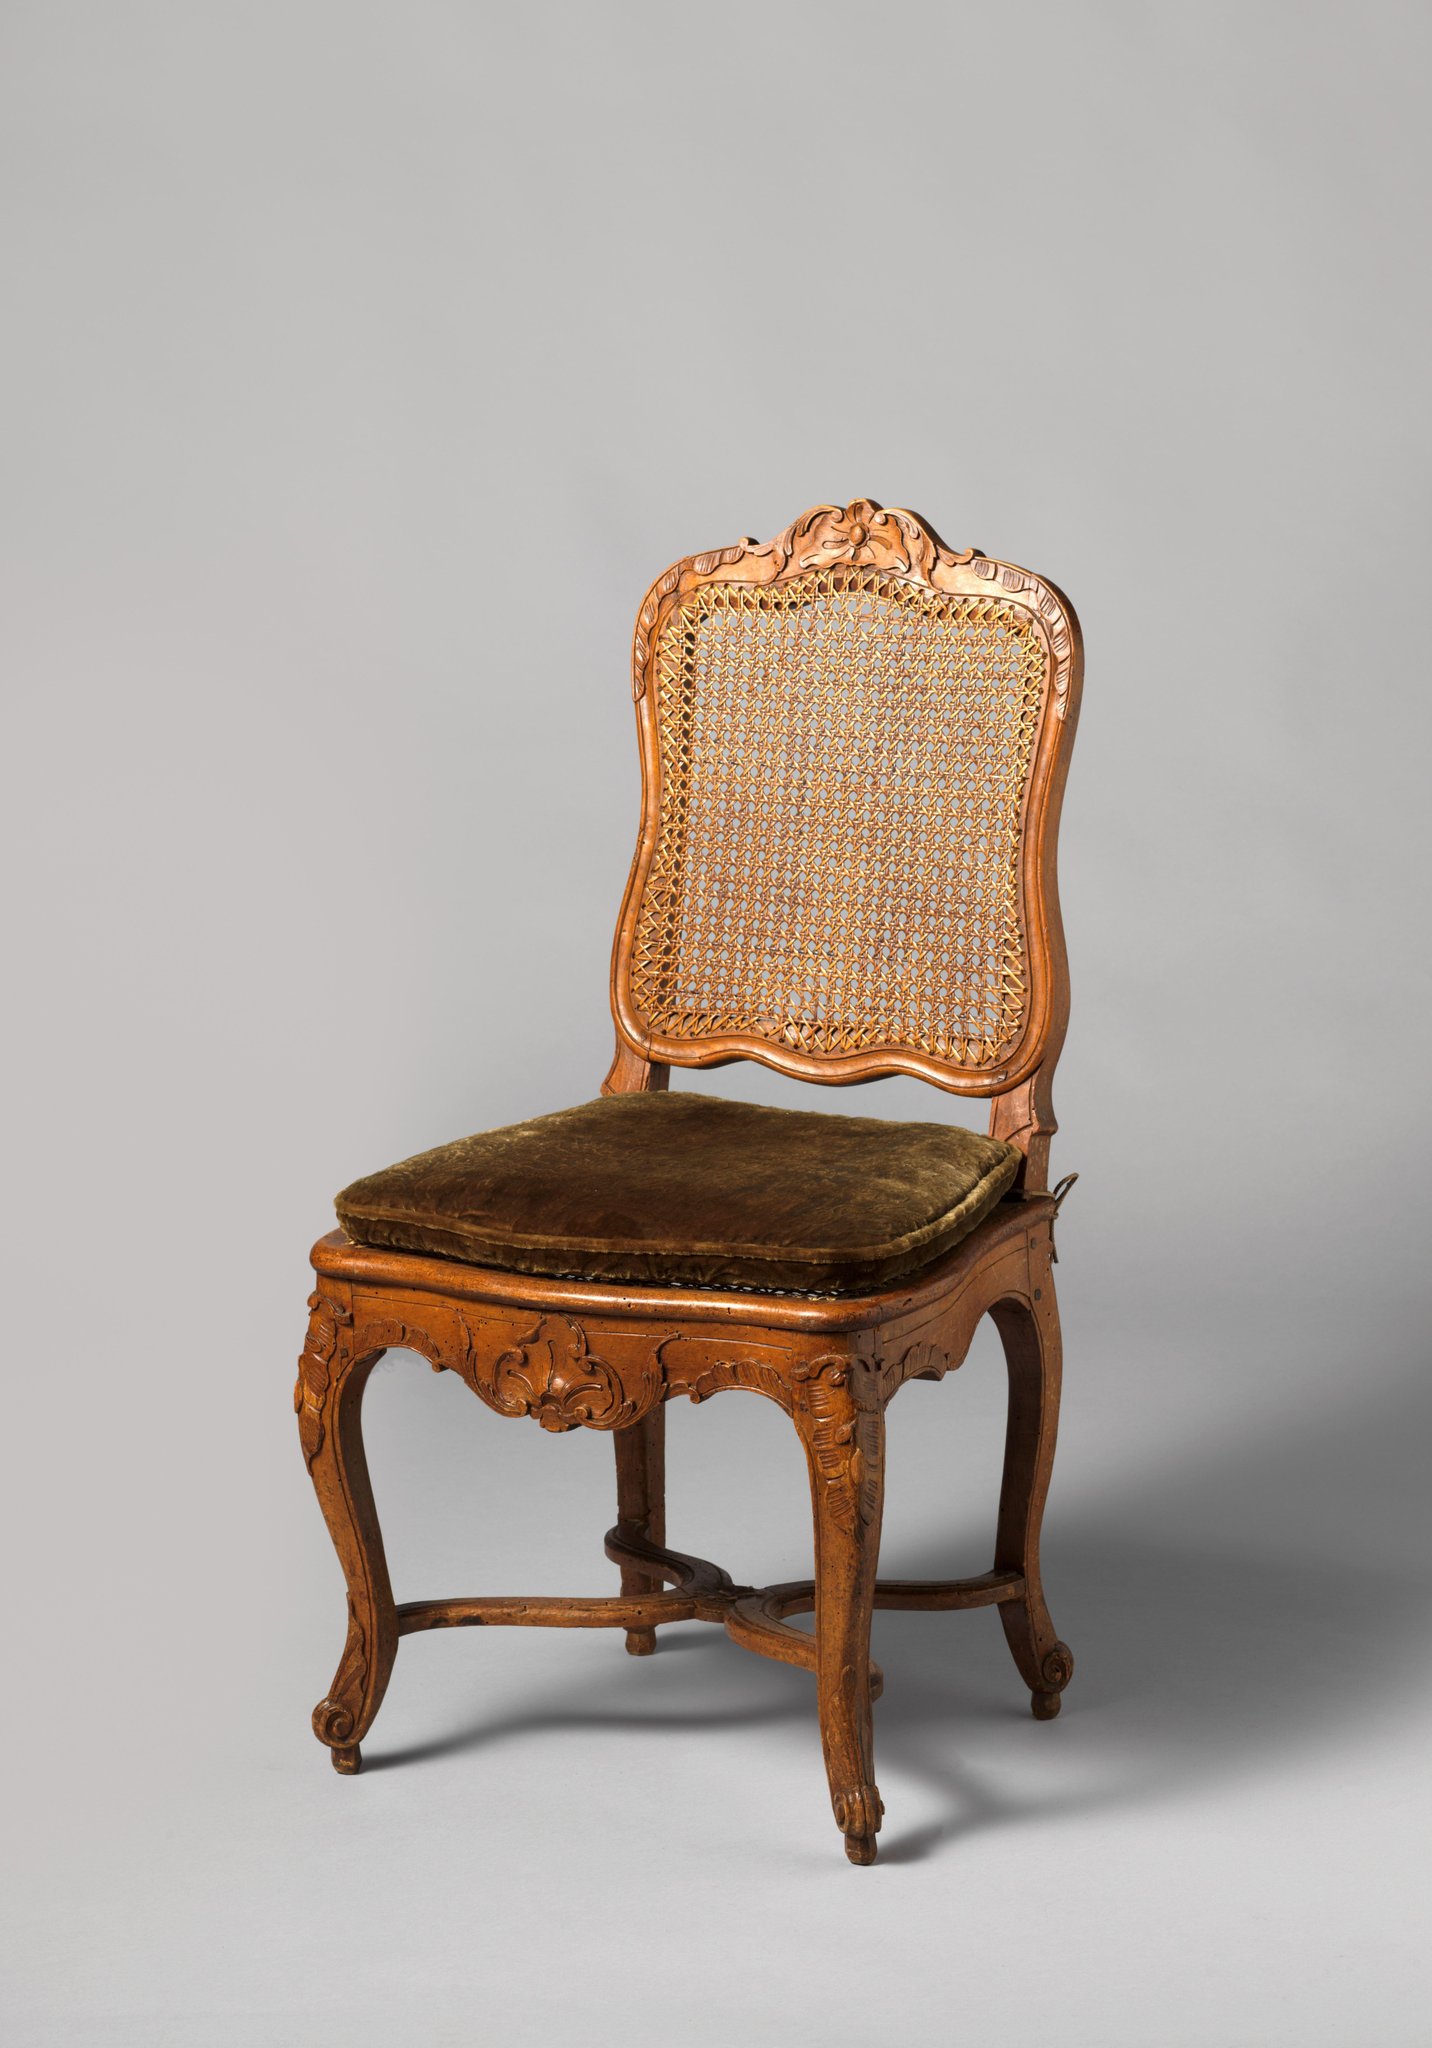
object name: seating furniture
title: Stoel van noten- en beukenhout met S-vormige overhoeks geplaatste poten; X-vormig kruis met rozet; gesneden bloem- en bladwerk, rug en zitting van riet, met los kussen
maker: Anonymous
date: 1750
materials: wood, textile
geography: france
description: Stoel van note- en beukehout (ameublement) met S-vormige overhoeks geplaatste poten, verbonden door een geslingerd X-vormig kruis met rozet. Regels en dorpels en poten zijn versierd met gesneden bloem- en bladmotieven. Rug en zitting van gevlochten riet. Los kussen van groen geschoren trijp (modern). Zie ook: BK-16852-E t/m P.